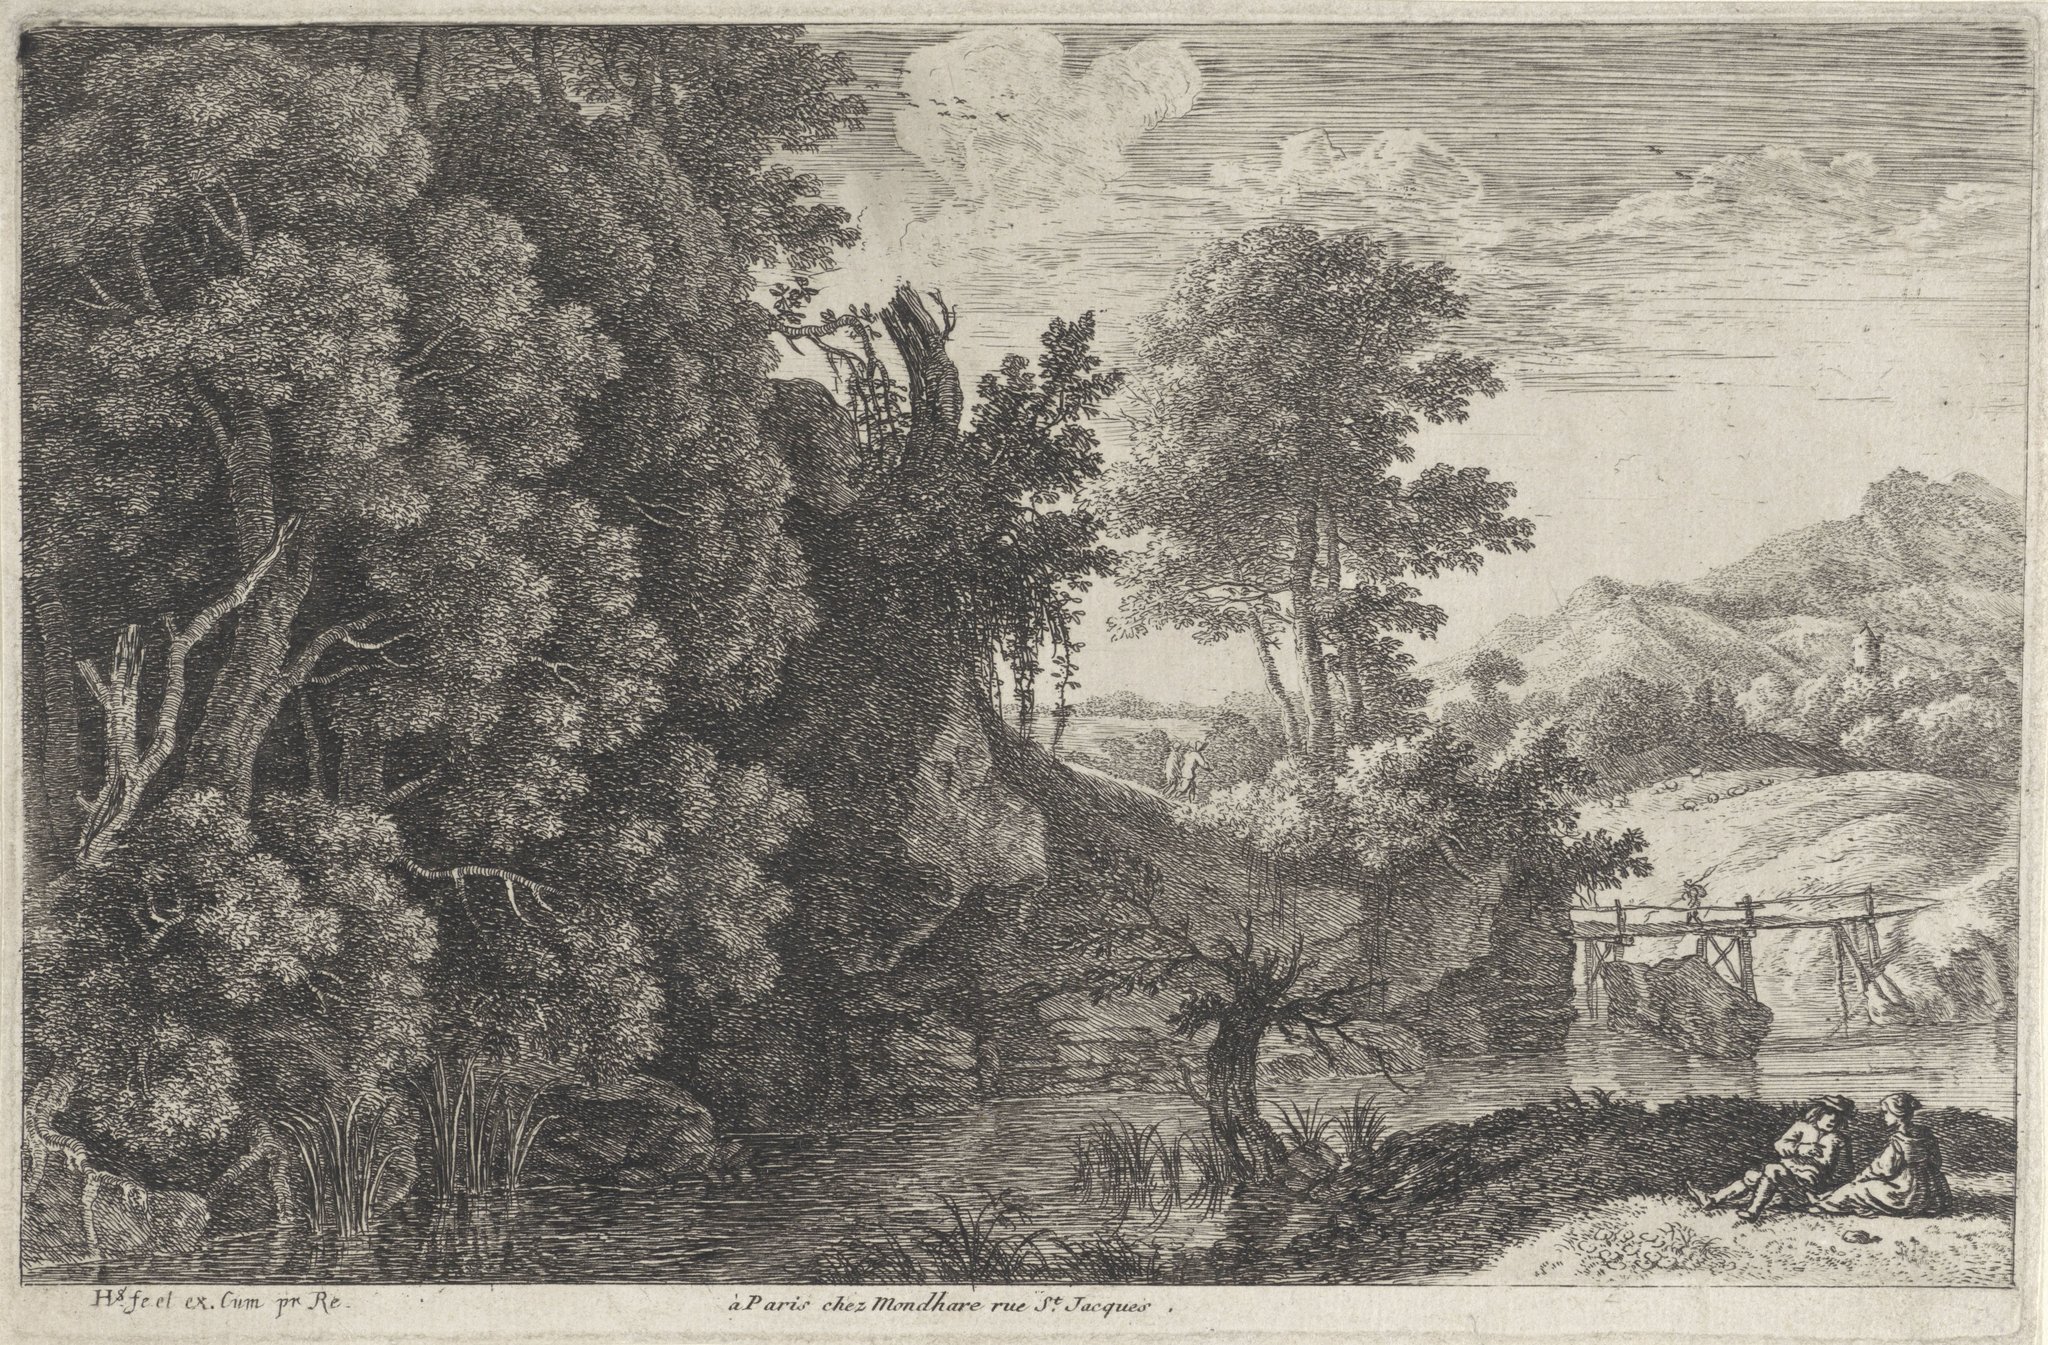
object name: print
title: Heuvellandschappen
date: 1759-1784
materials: paper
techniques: etching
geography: paris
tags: landscapes, landscape with bridge, viaduct or aqueduct, rural housing, e.g. country-house, villa, cottage, (high) hill, bridge, 'en route', traveller under way, tower (of house or building), resting - bb - out of doors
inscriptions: collector's mark: Lugt 2228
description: Aan de oever van een rivier rusten een man en een vrouw. In de verte loopt een figuur over een kleine houten brug en in de heuvels ligt een gebouw met een toren.